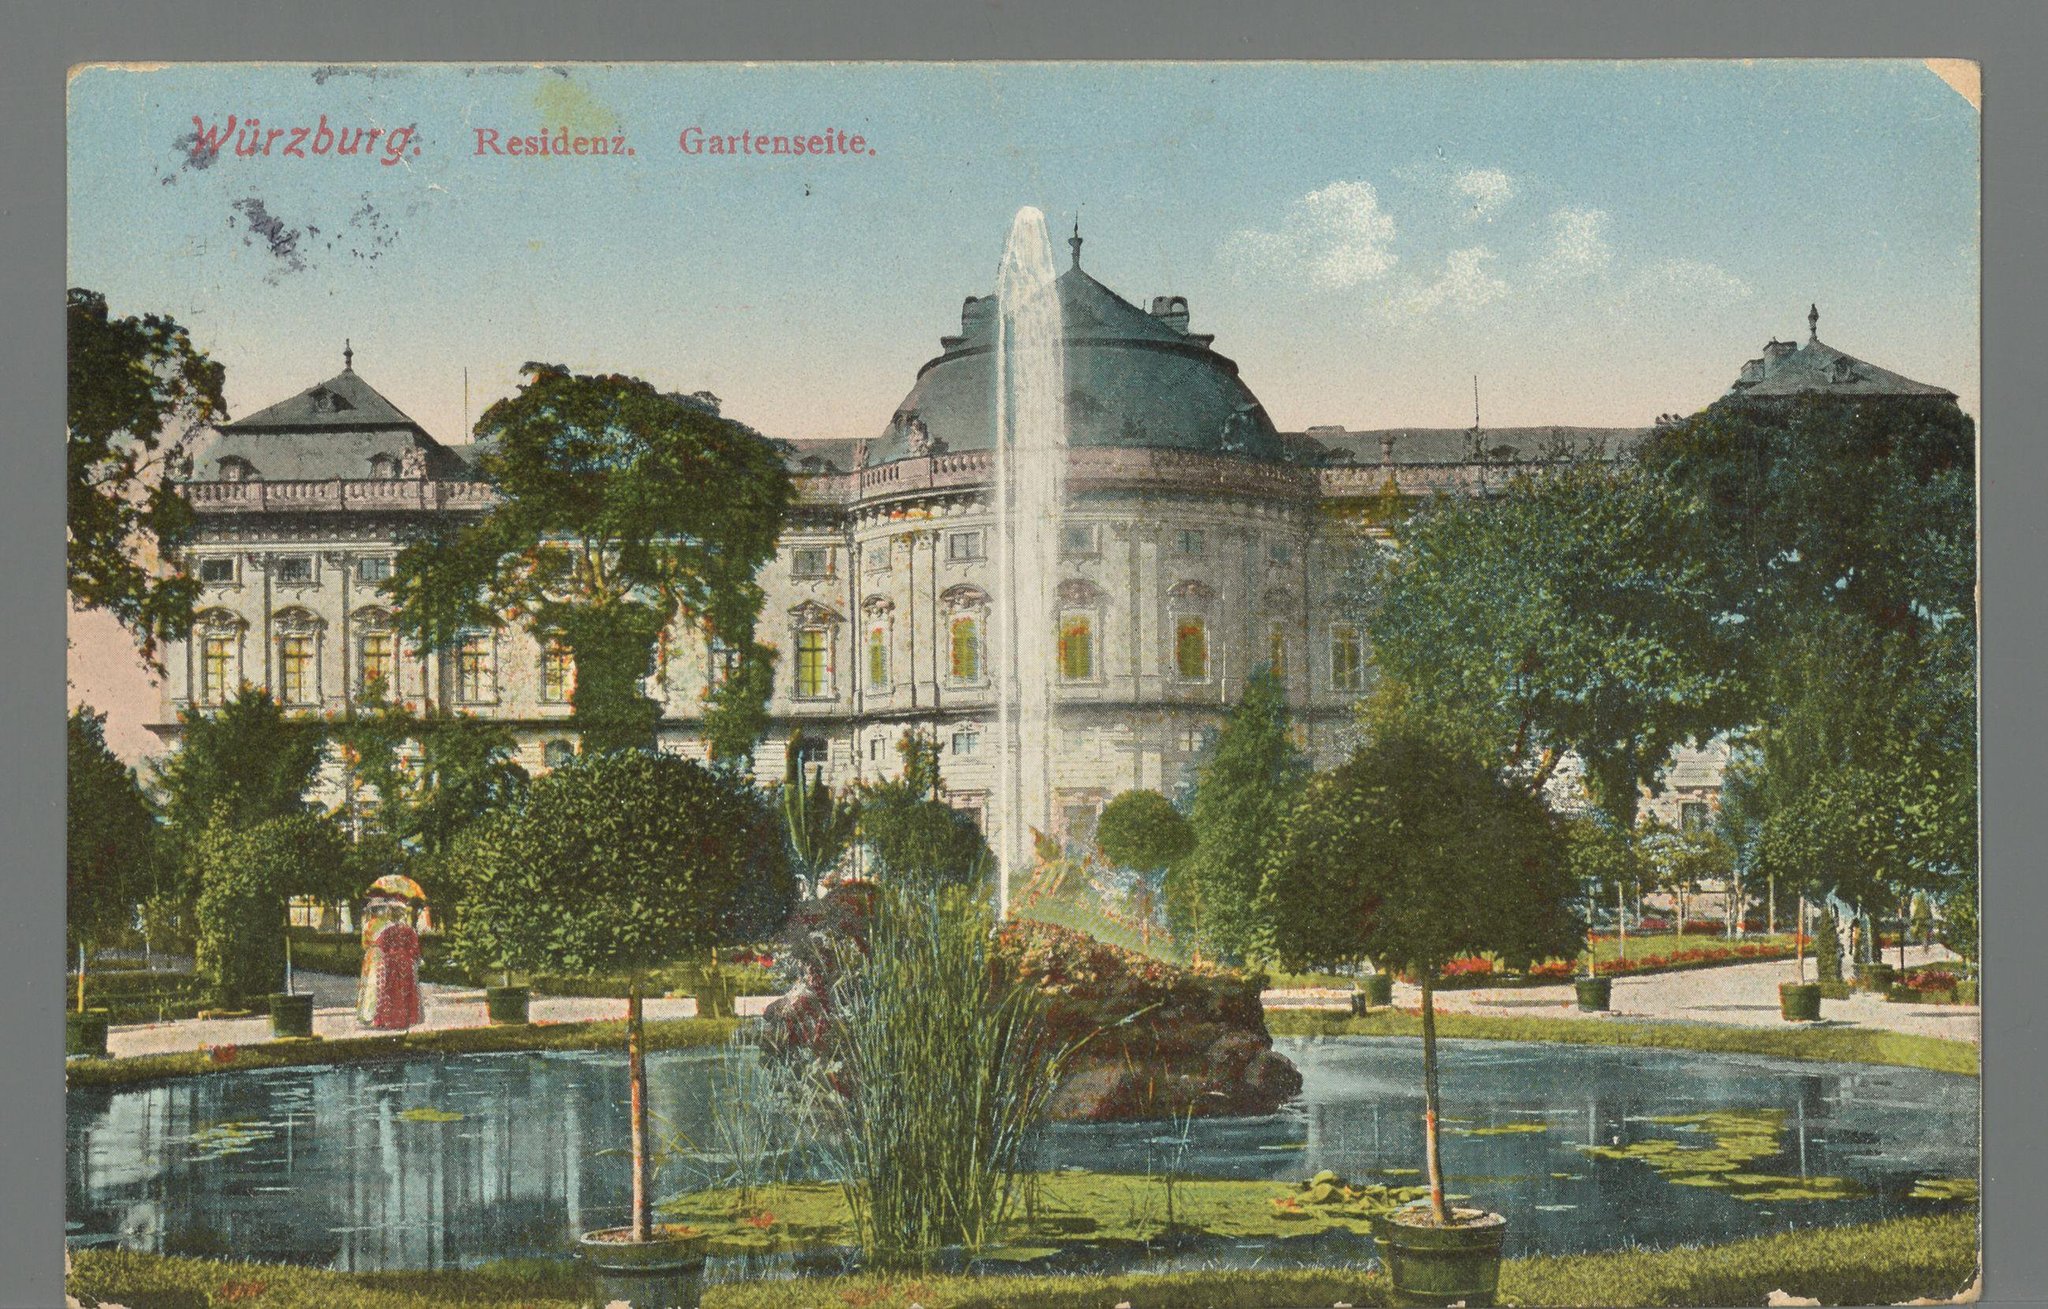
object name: ansichtkaart, prentbriefkaart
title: Würzburg. Residenz. Gartenseite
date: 1905-1930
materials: cardboard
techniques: lithograph, writing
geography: würzburg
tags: garden fountain, palace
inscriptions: poststempel, verso, gestempeld